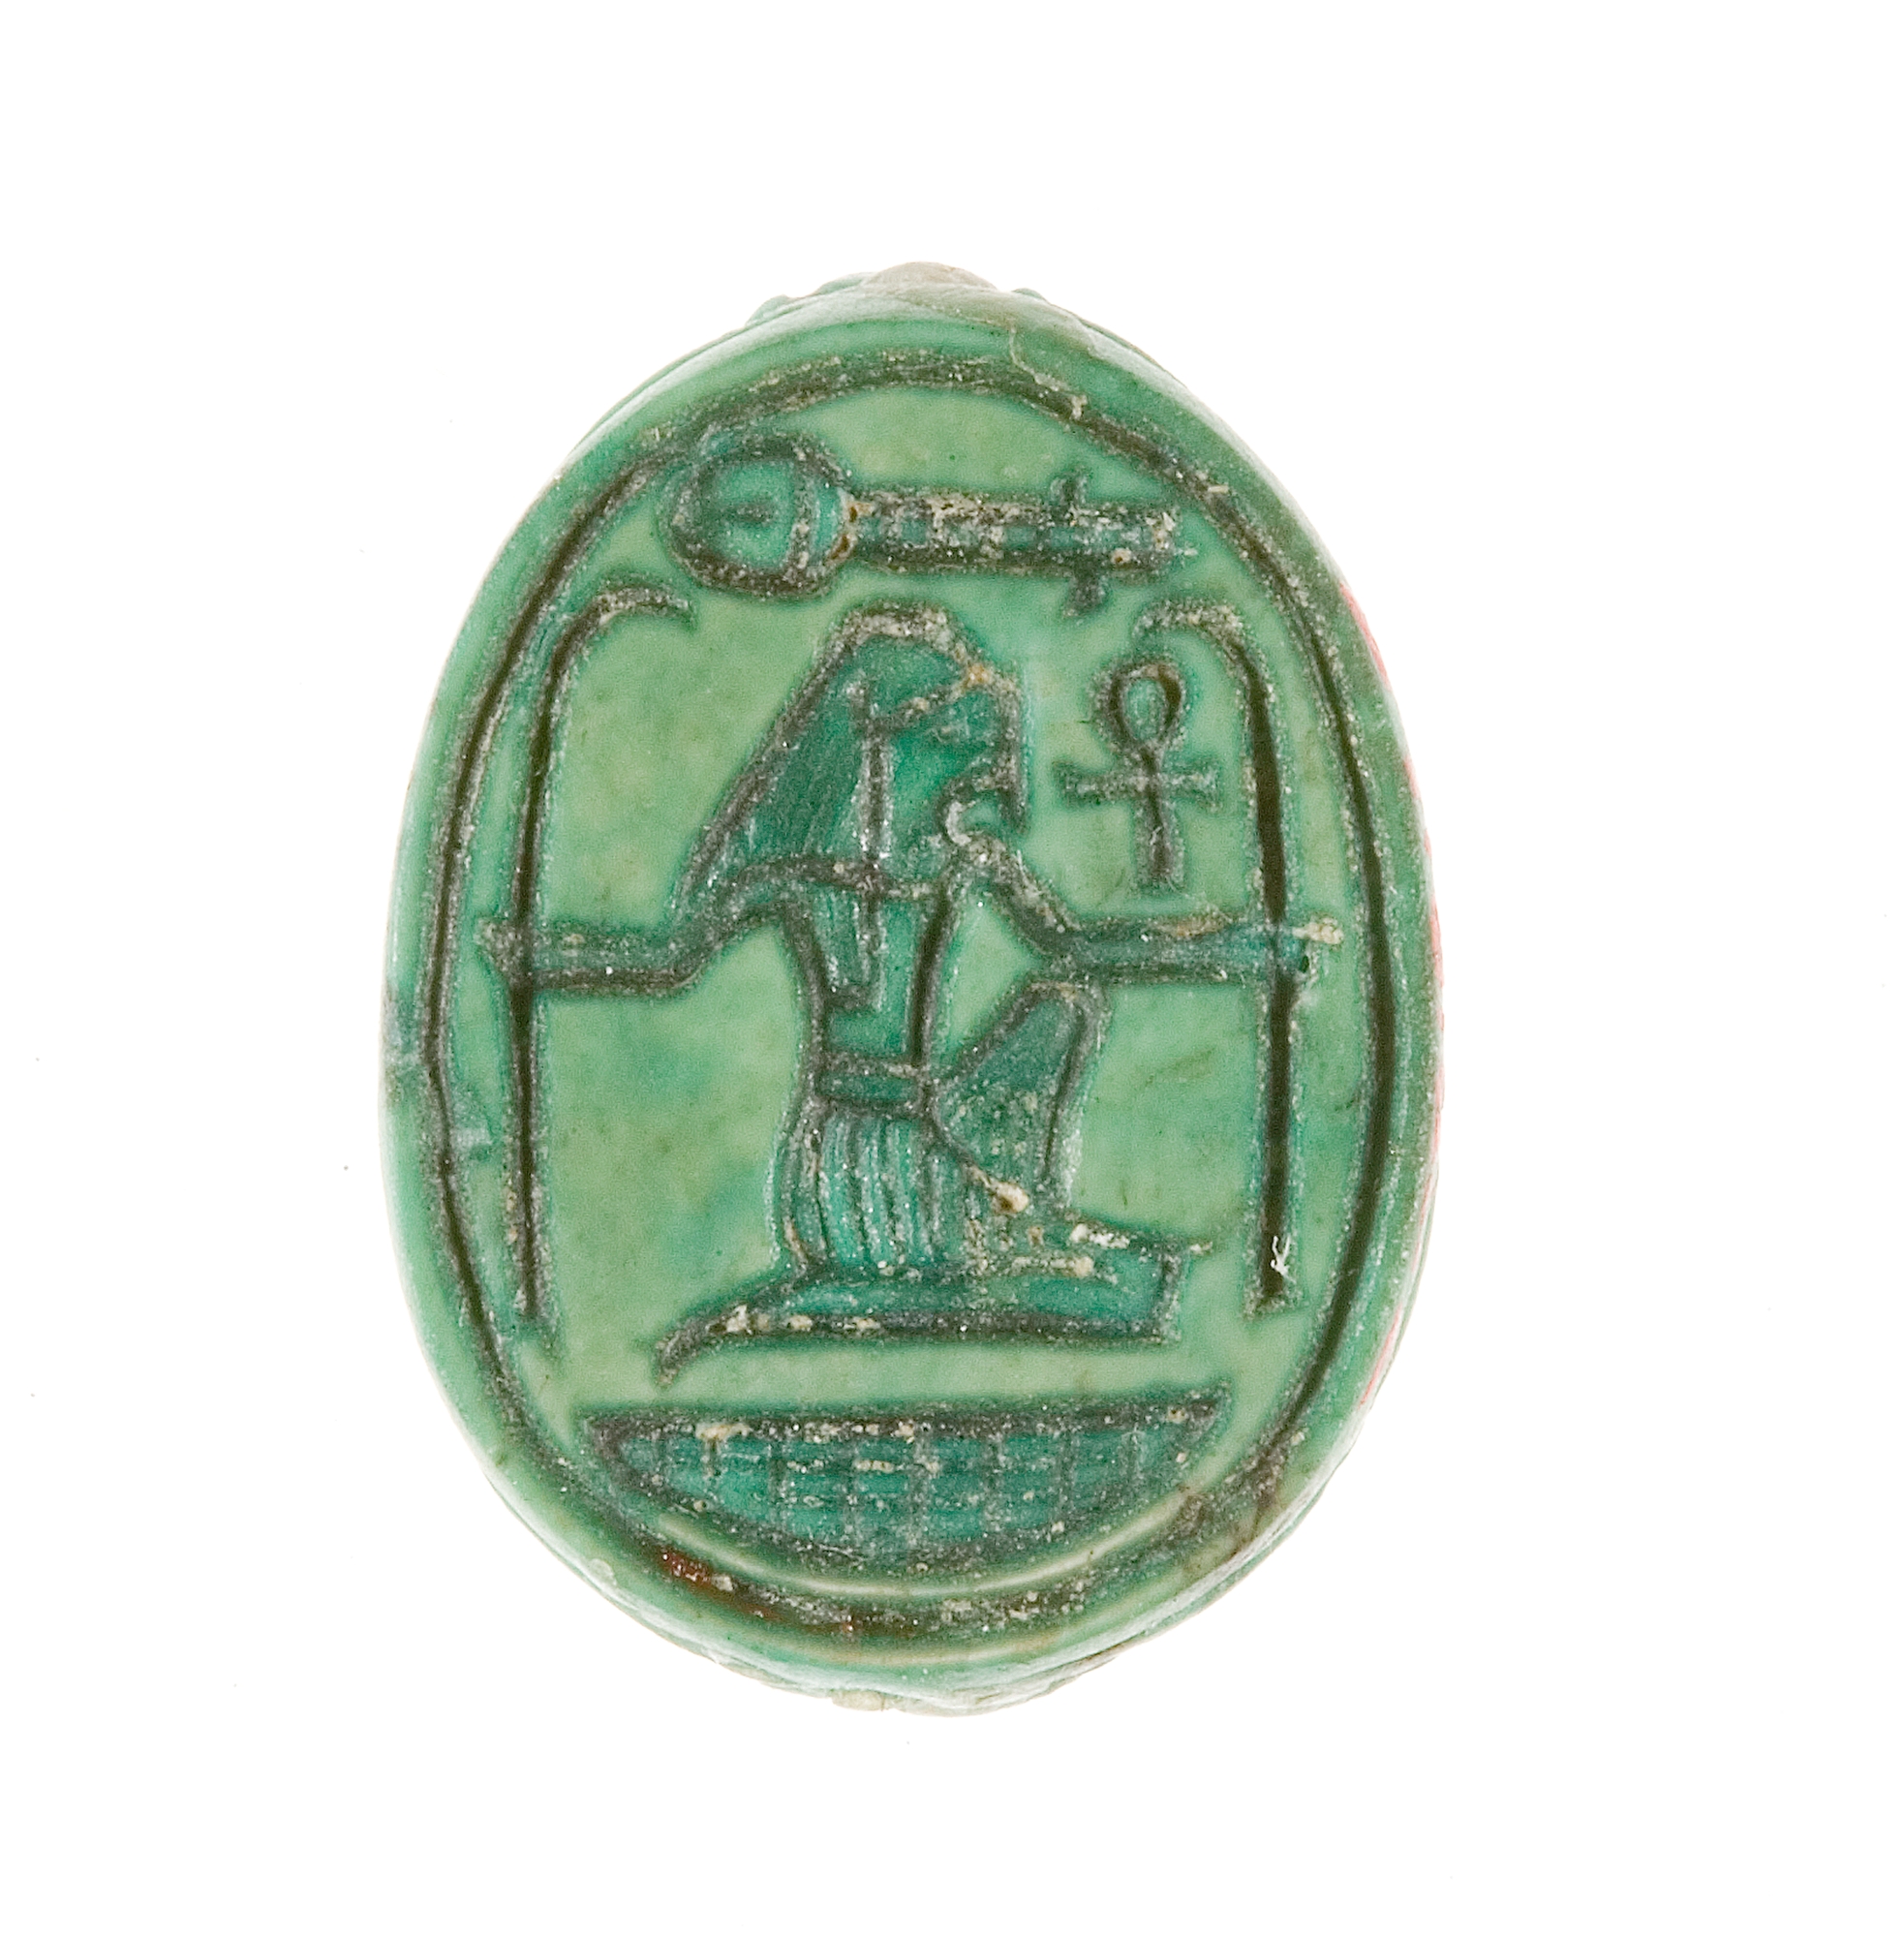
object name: scarab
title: Scarab Inscribed with a Hieroglyphic Motif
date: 1479-1458 BCE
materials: stone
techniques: glazing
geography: egypt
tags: hieroglyphs,scarabs